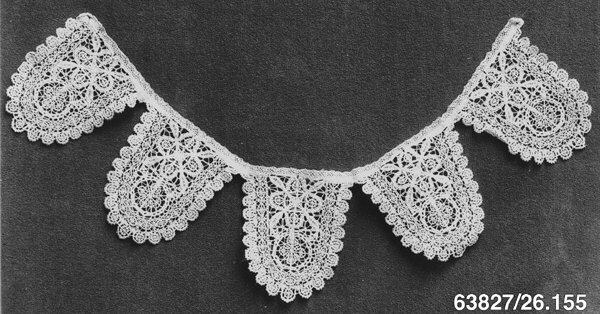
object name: collar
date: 1601-1633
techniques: lace